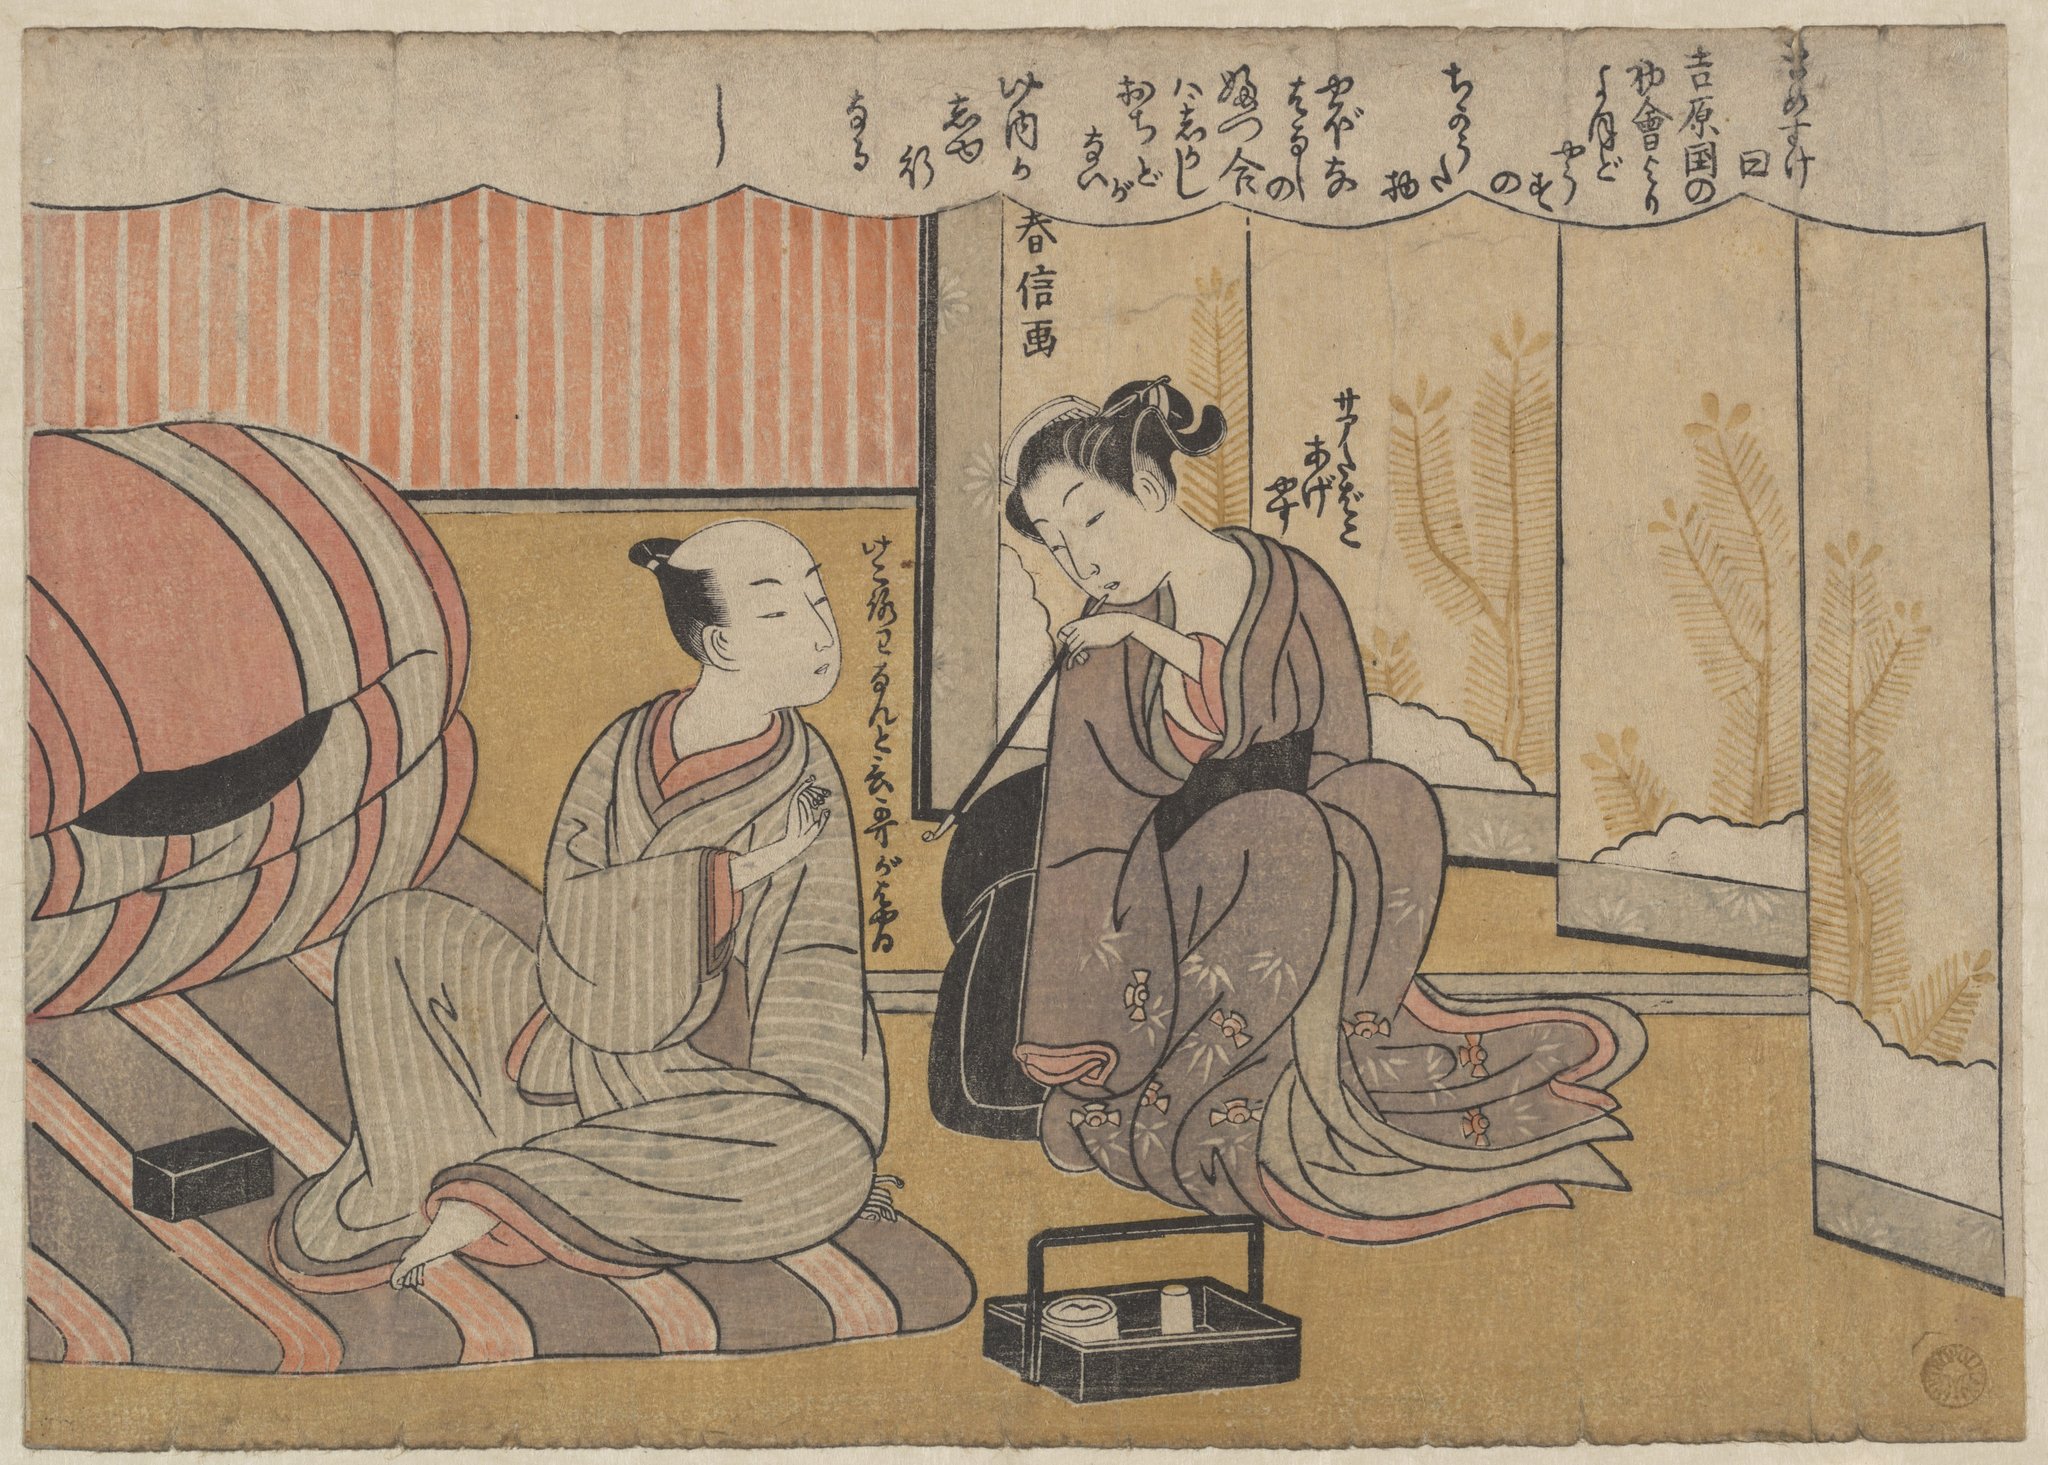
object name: print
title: The Art of Conversation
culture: japanese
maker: suzuki harunobu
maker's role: artist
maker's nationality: japanese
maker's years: 1725-1770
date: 1725-1770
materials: ink, paper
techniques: woodblock print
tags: men,women